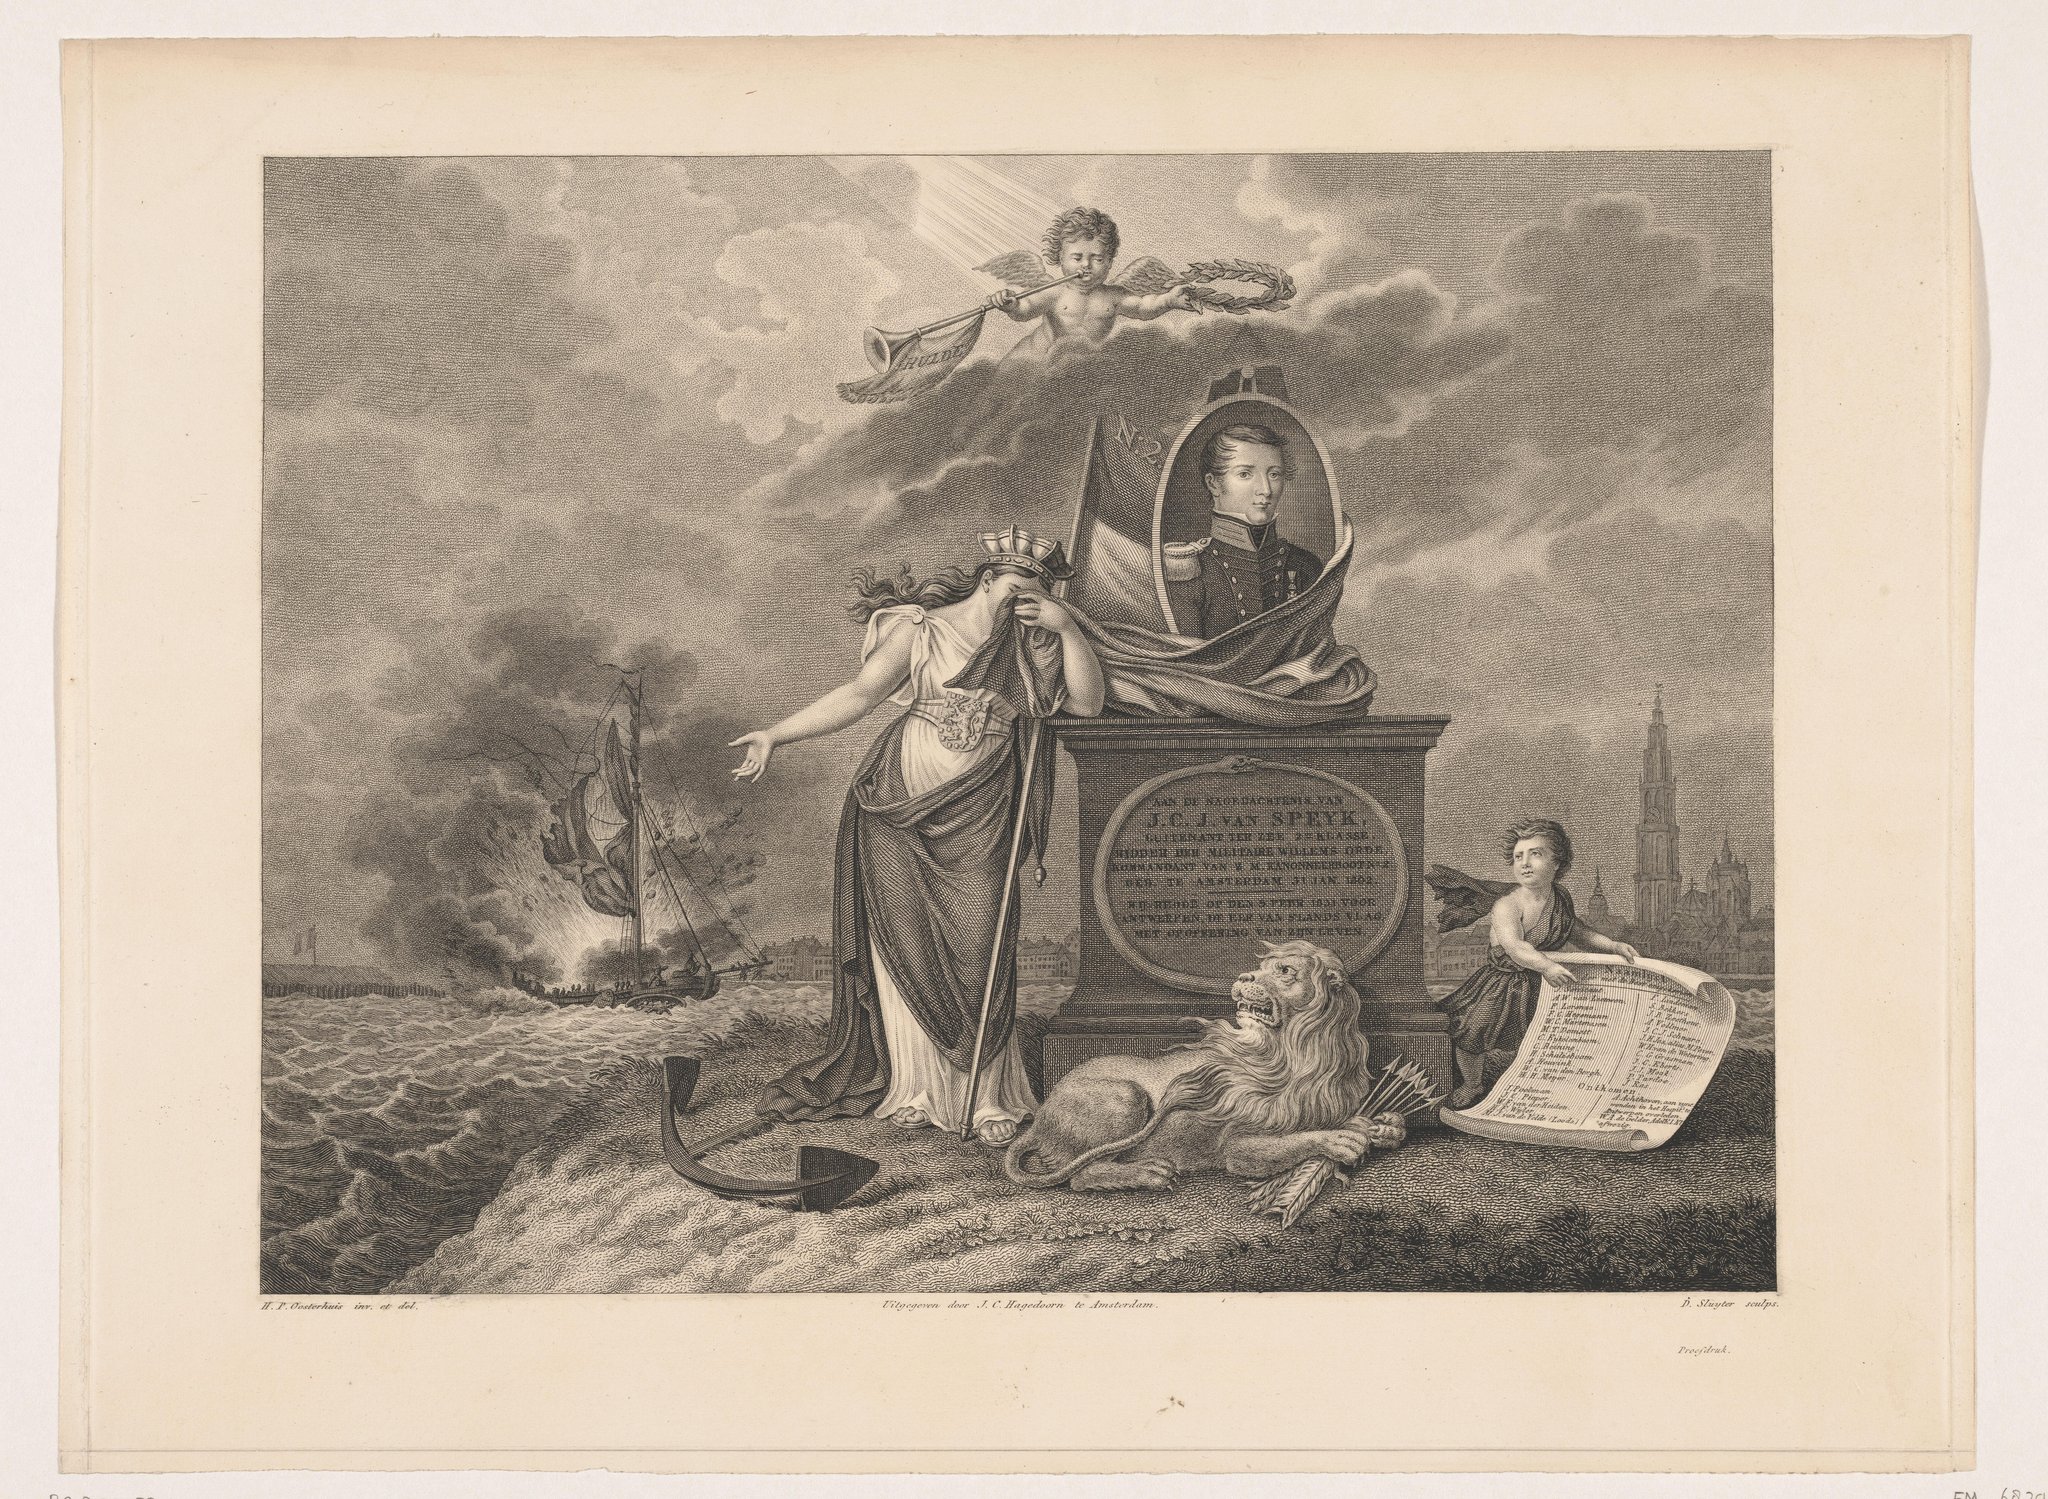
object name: print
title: Monument voor Jan van Speyk, 1832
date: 1832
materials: paper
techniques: engraving, etching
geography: netherlands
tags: antwerp, jan van speyk, personifications of countries, nations, states, districts, etc., mourning the dead, navy (+ sailing-ships), self-sacrifice, death in the service of a higher purpose, gunpowder disaster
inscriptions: collector's mark: Lugt 2228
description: Een allegorisch grafmonument ter nagedachtenis aan Jan van Speyk, 1832. De Nederlandse Maagd huilend bij het monument met portret en opschrift, opgericht aan de Vlaamse kust. Links de ontploffing van de kanonneerboot van Van Speyk, rechts de stad Antwerpen. Op de grond voor het monument ligt de Nederlandse leeuw, rechts een kind met de namen van de slachtoffers omgekomen op de boot. Vervaardiging mogelijk naar aanleiding van zijn begrafenis in Amsterdam op 4 mei 1832.